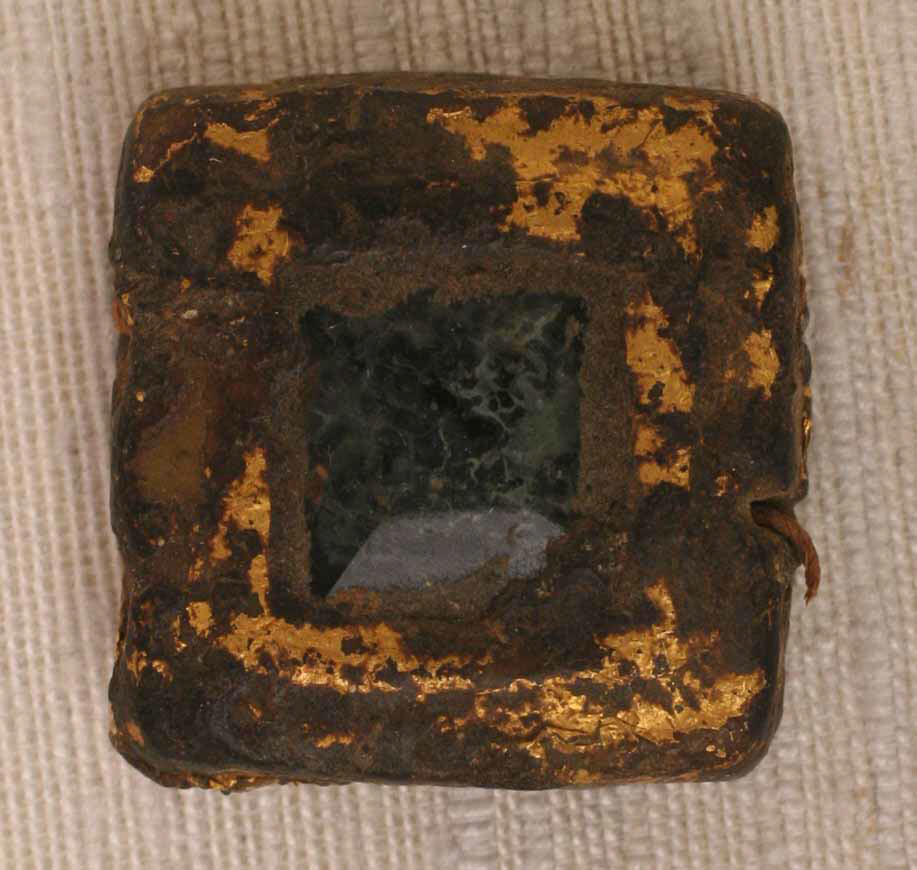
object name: plaque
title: Plaque for a Collar or Necklace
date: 701-800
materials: gold, mother of pearl, stone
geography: egypt